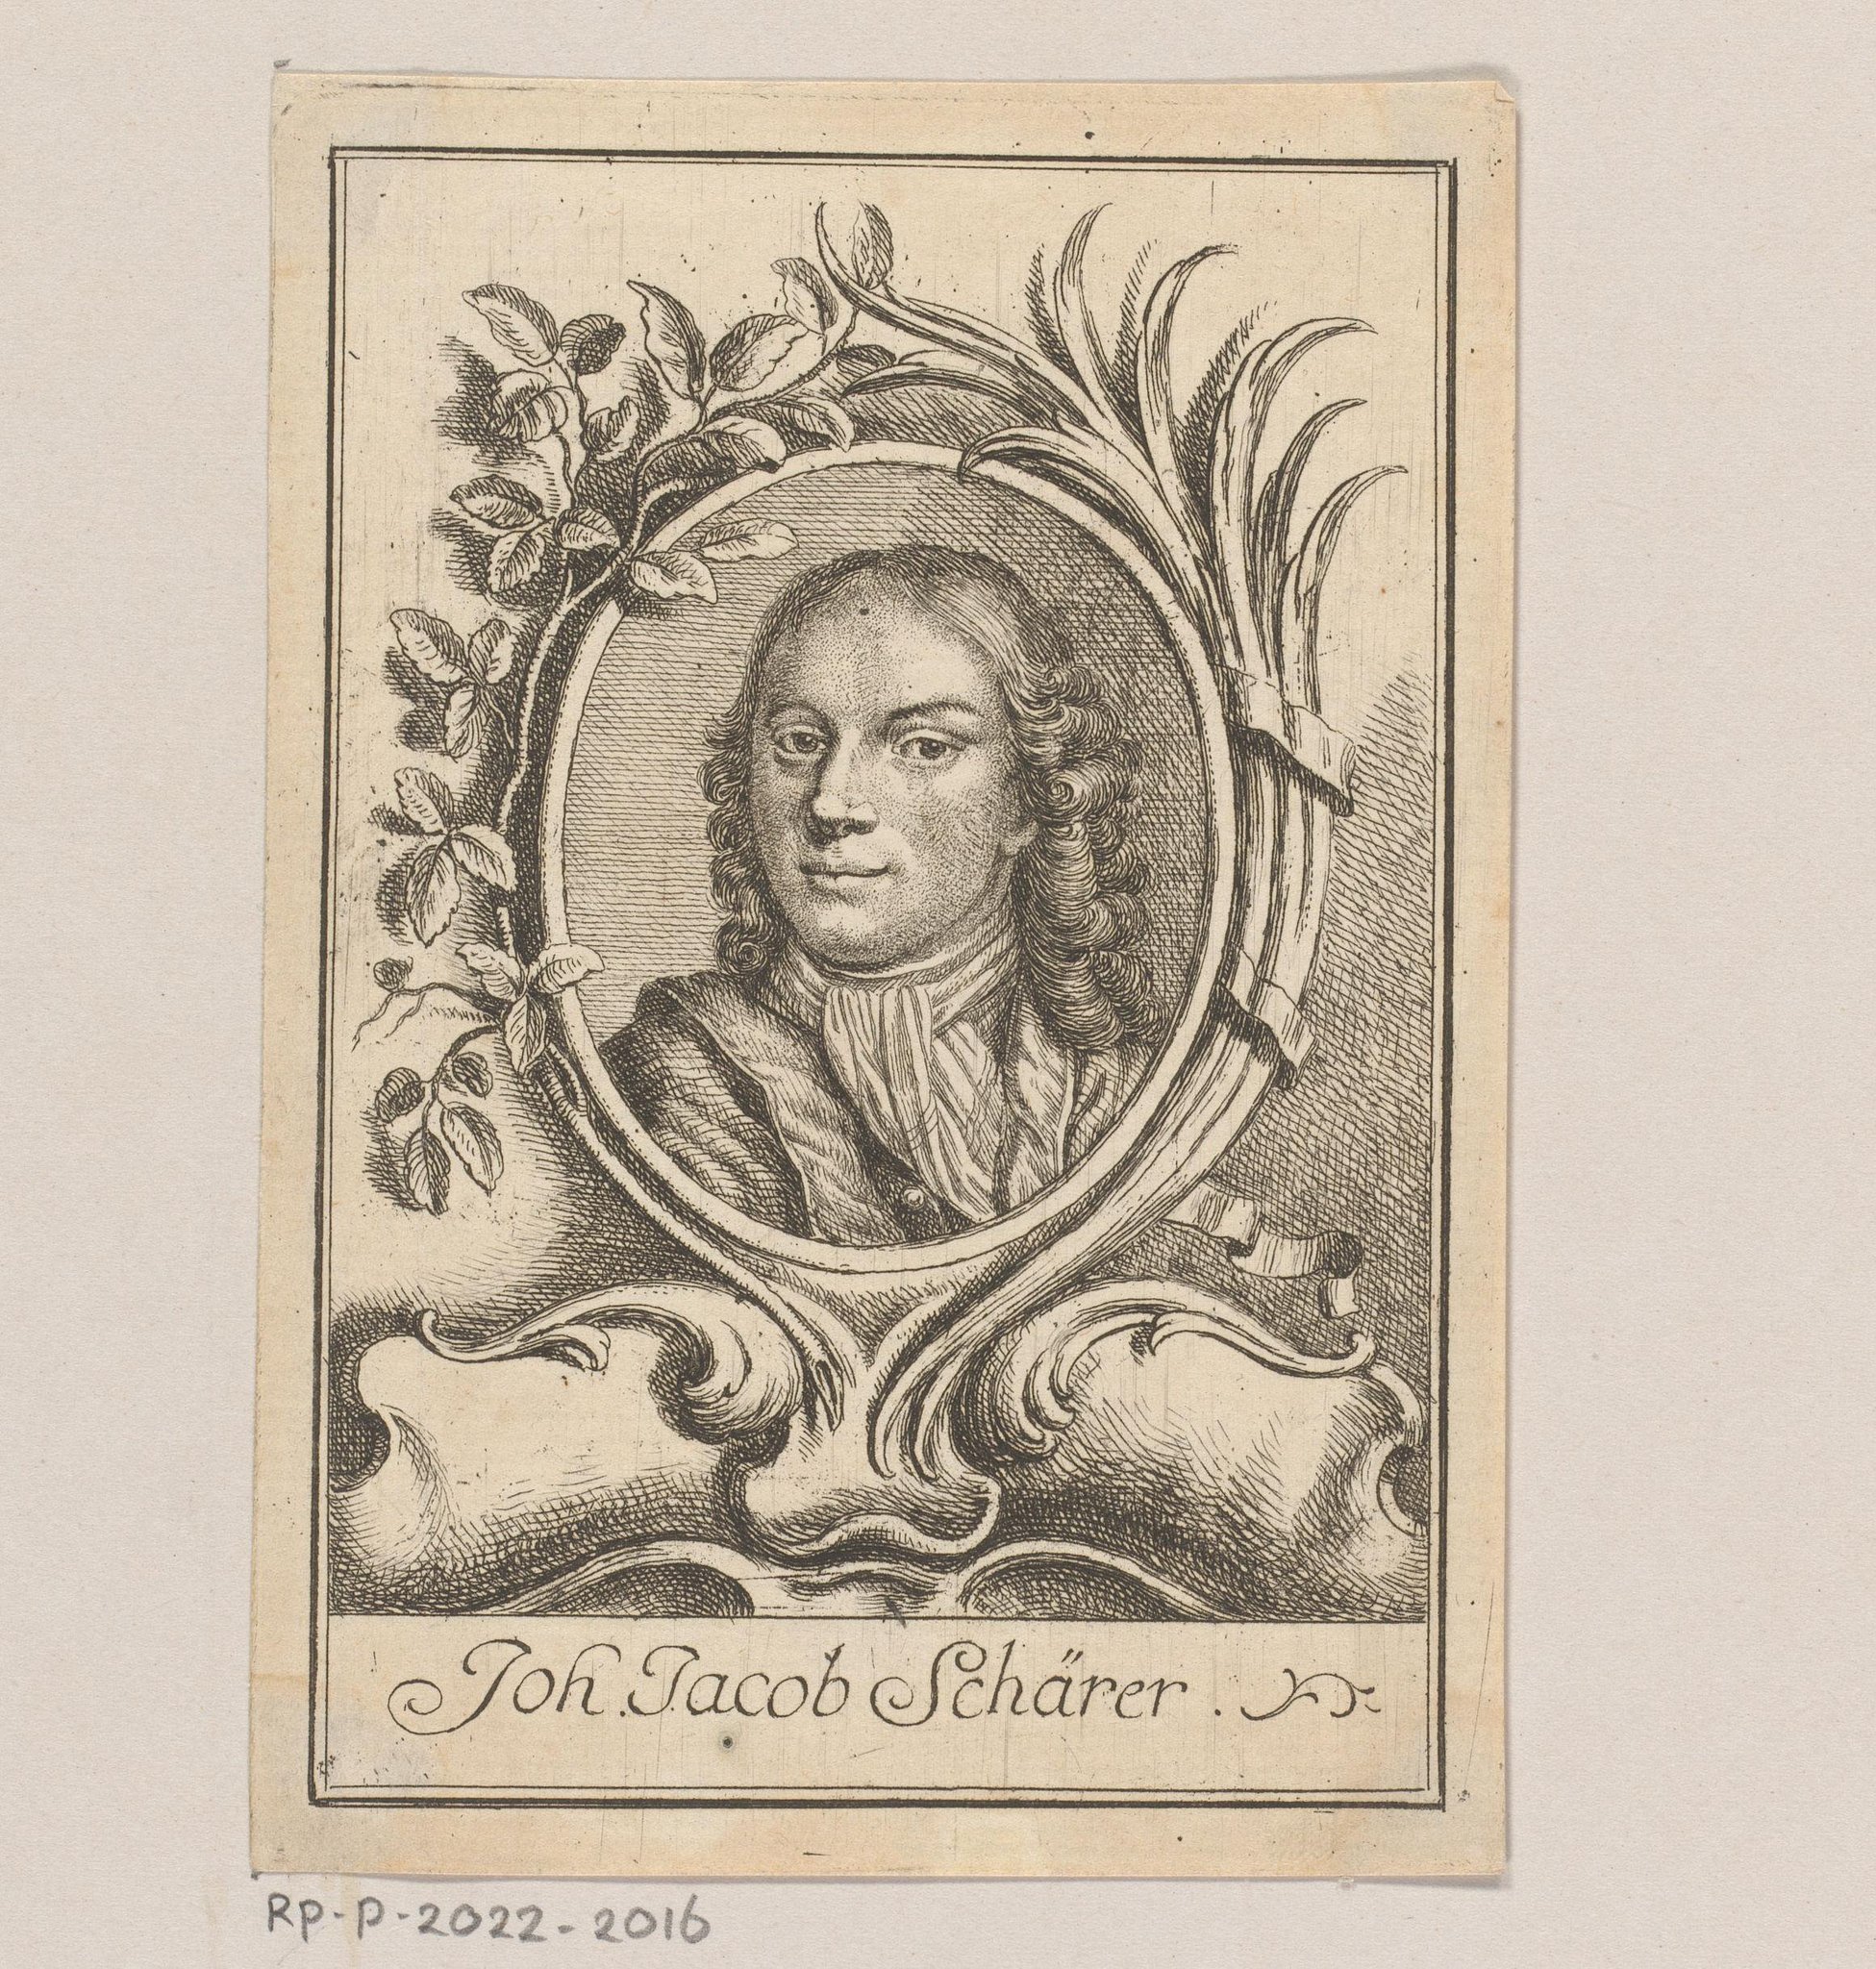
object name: print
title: Portret van Johann Jakob Schärer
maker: Anonymous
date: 1696-1750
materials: paper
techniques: etching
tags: painter, johann jakob schärer, historical persons, portrait, self-portrait of artist